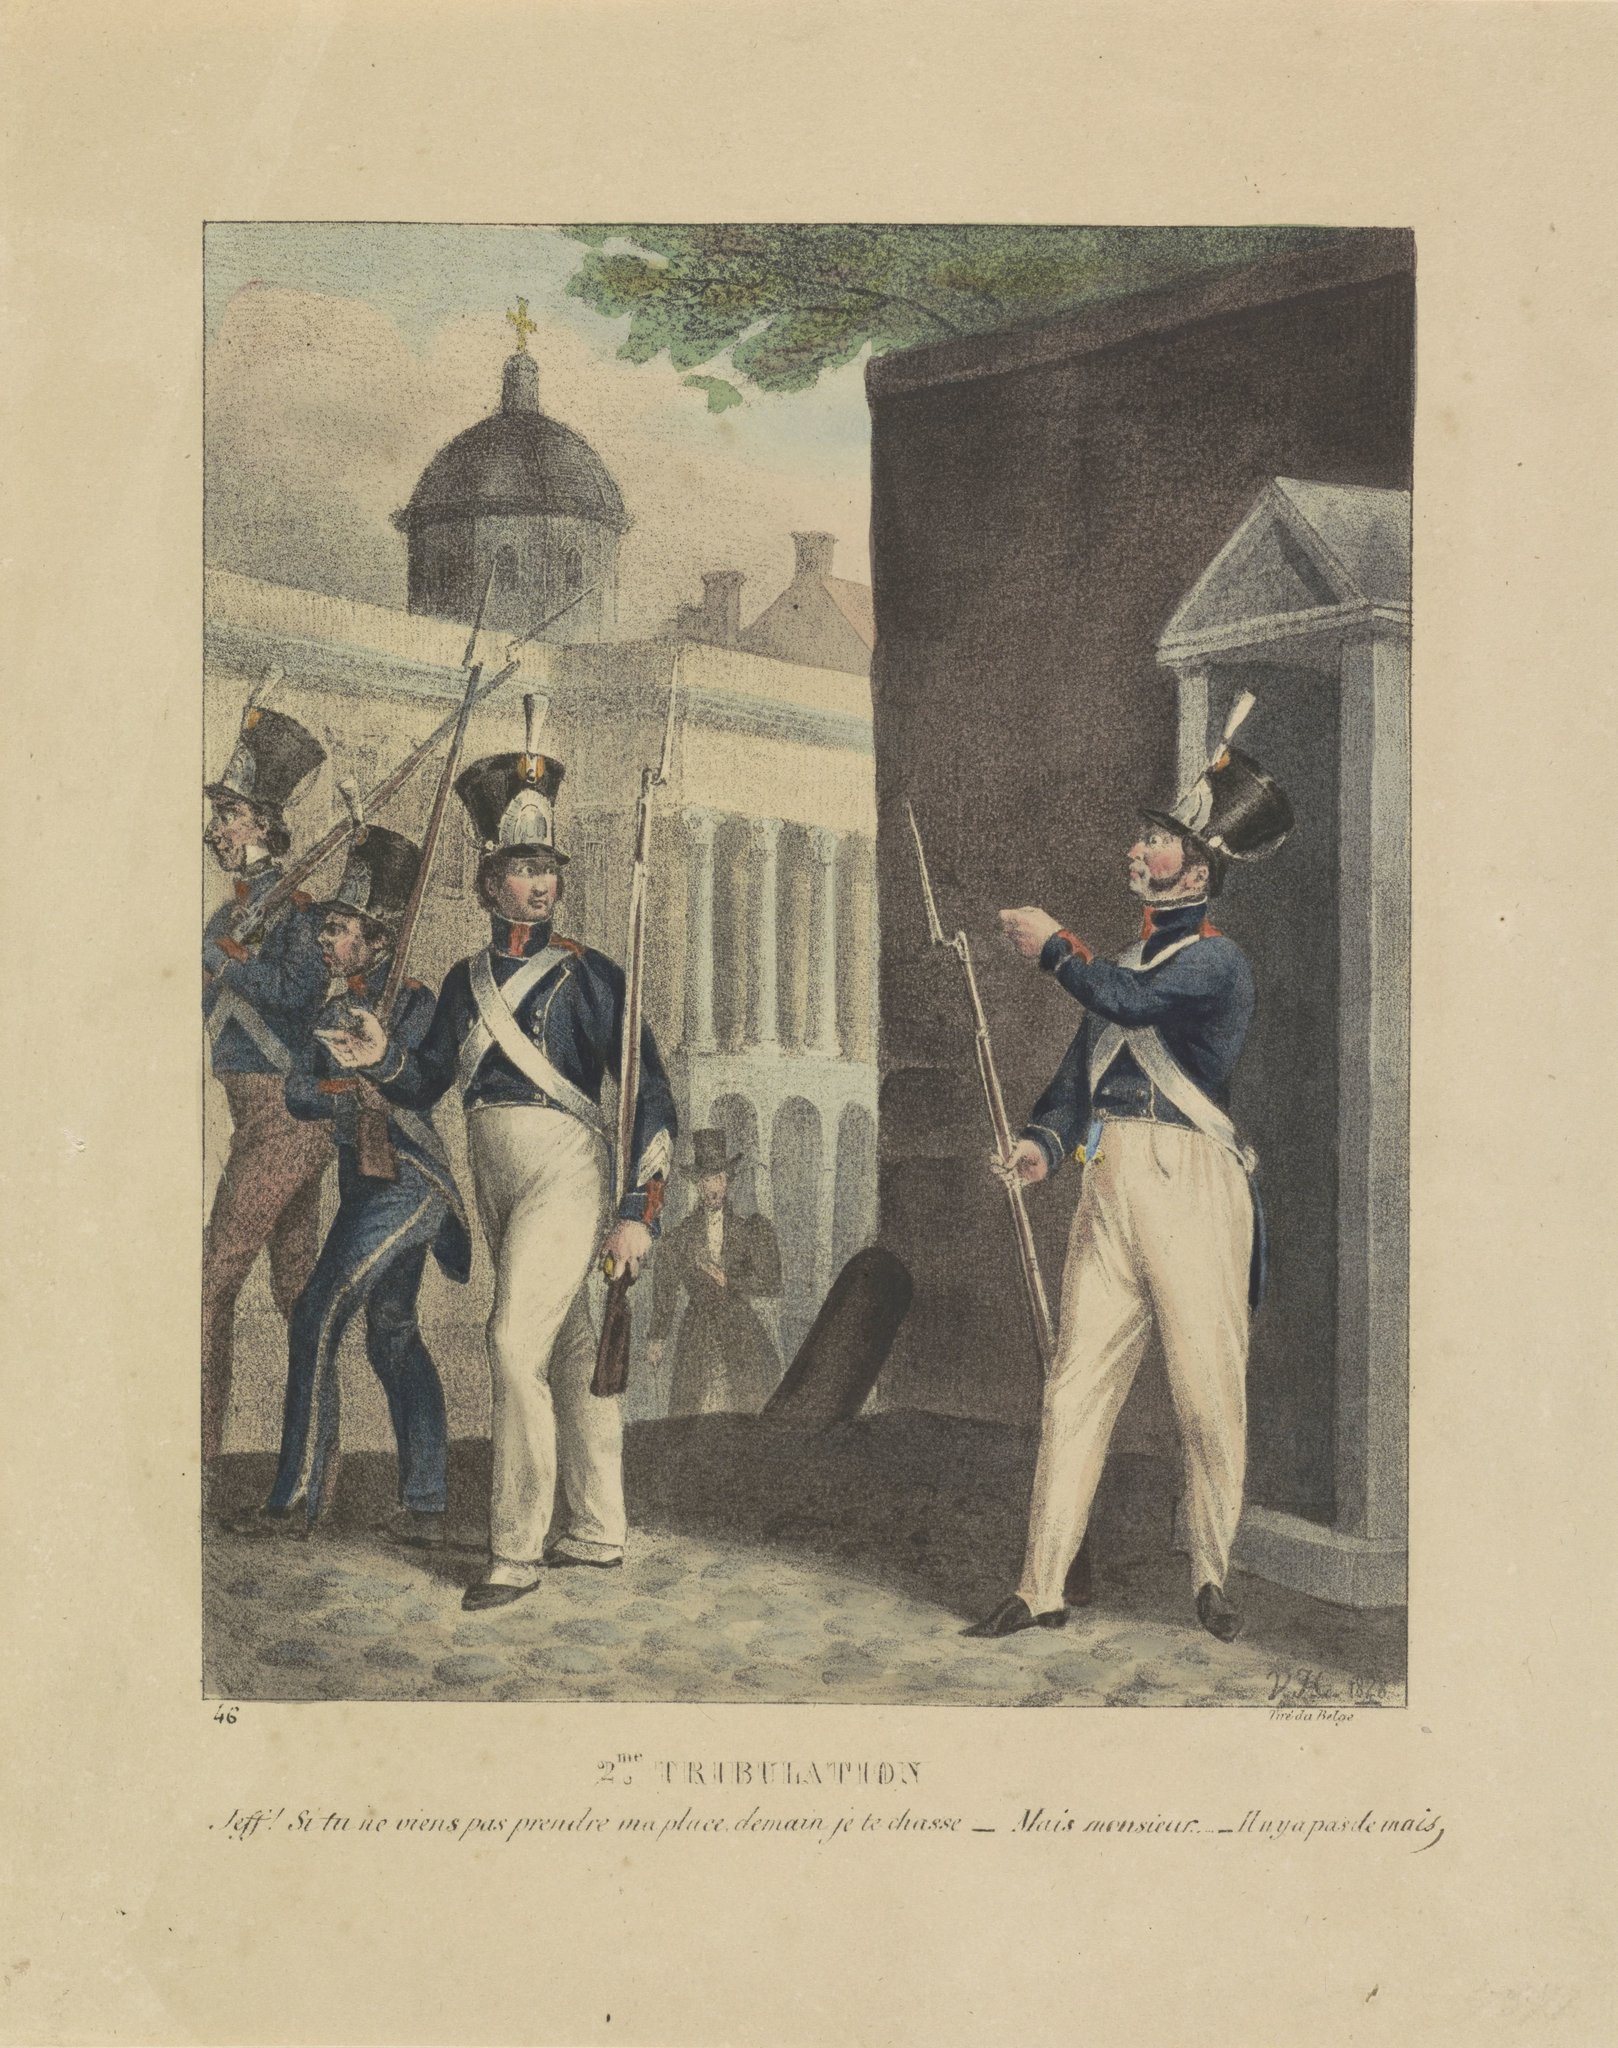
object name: print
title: 2me Tribulation. Jeff! si tu ne viens pas prendre ma place, demain je te chasse - Mais monsieur - Il n y a pas de mais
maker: jean-louis van hemelryck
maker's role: print maker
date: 1828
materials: paper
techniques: hand coloring, lithograph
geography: southern netherlands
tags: the soldier; the soldier's life, belgium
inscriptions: collector's mark: Lugt 2228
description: Een heer die op wacht staat dreigt met zijn vuist naar zijn voormalige bediende die nu korporaal is geworden. Linksonder genummerd 46. Onderdeel van een serie van ca. 24 spotprenten uit 1828 op de wanverhoudingen binnen de Belgische schutterijen door de maatschappelijke ongelijkheid binnen het korps, na de reorganisatie ingevoerd op 11 april 1827.